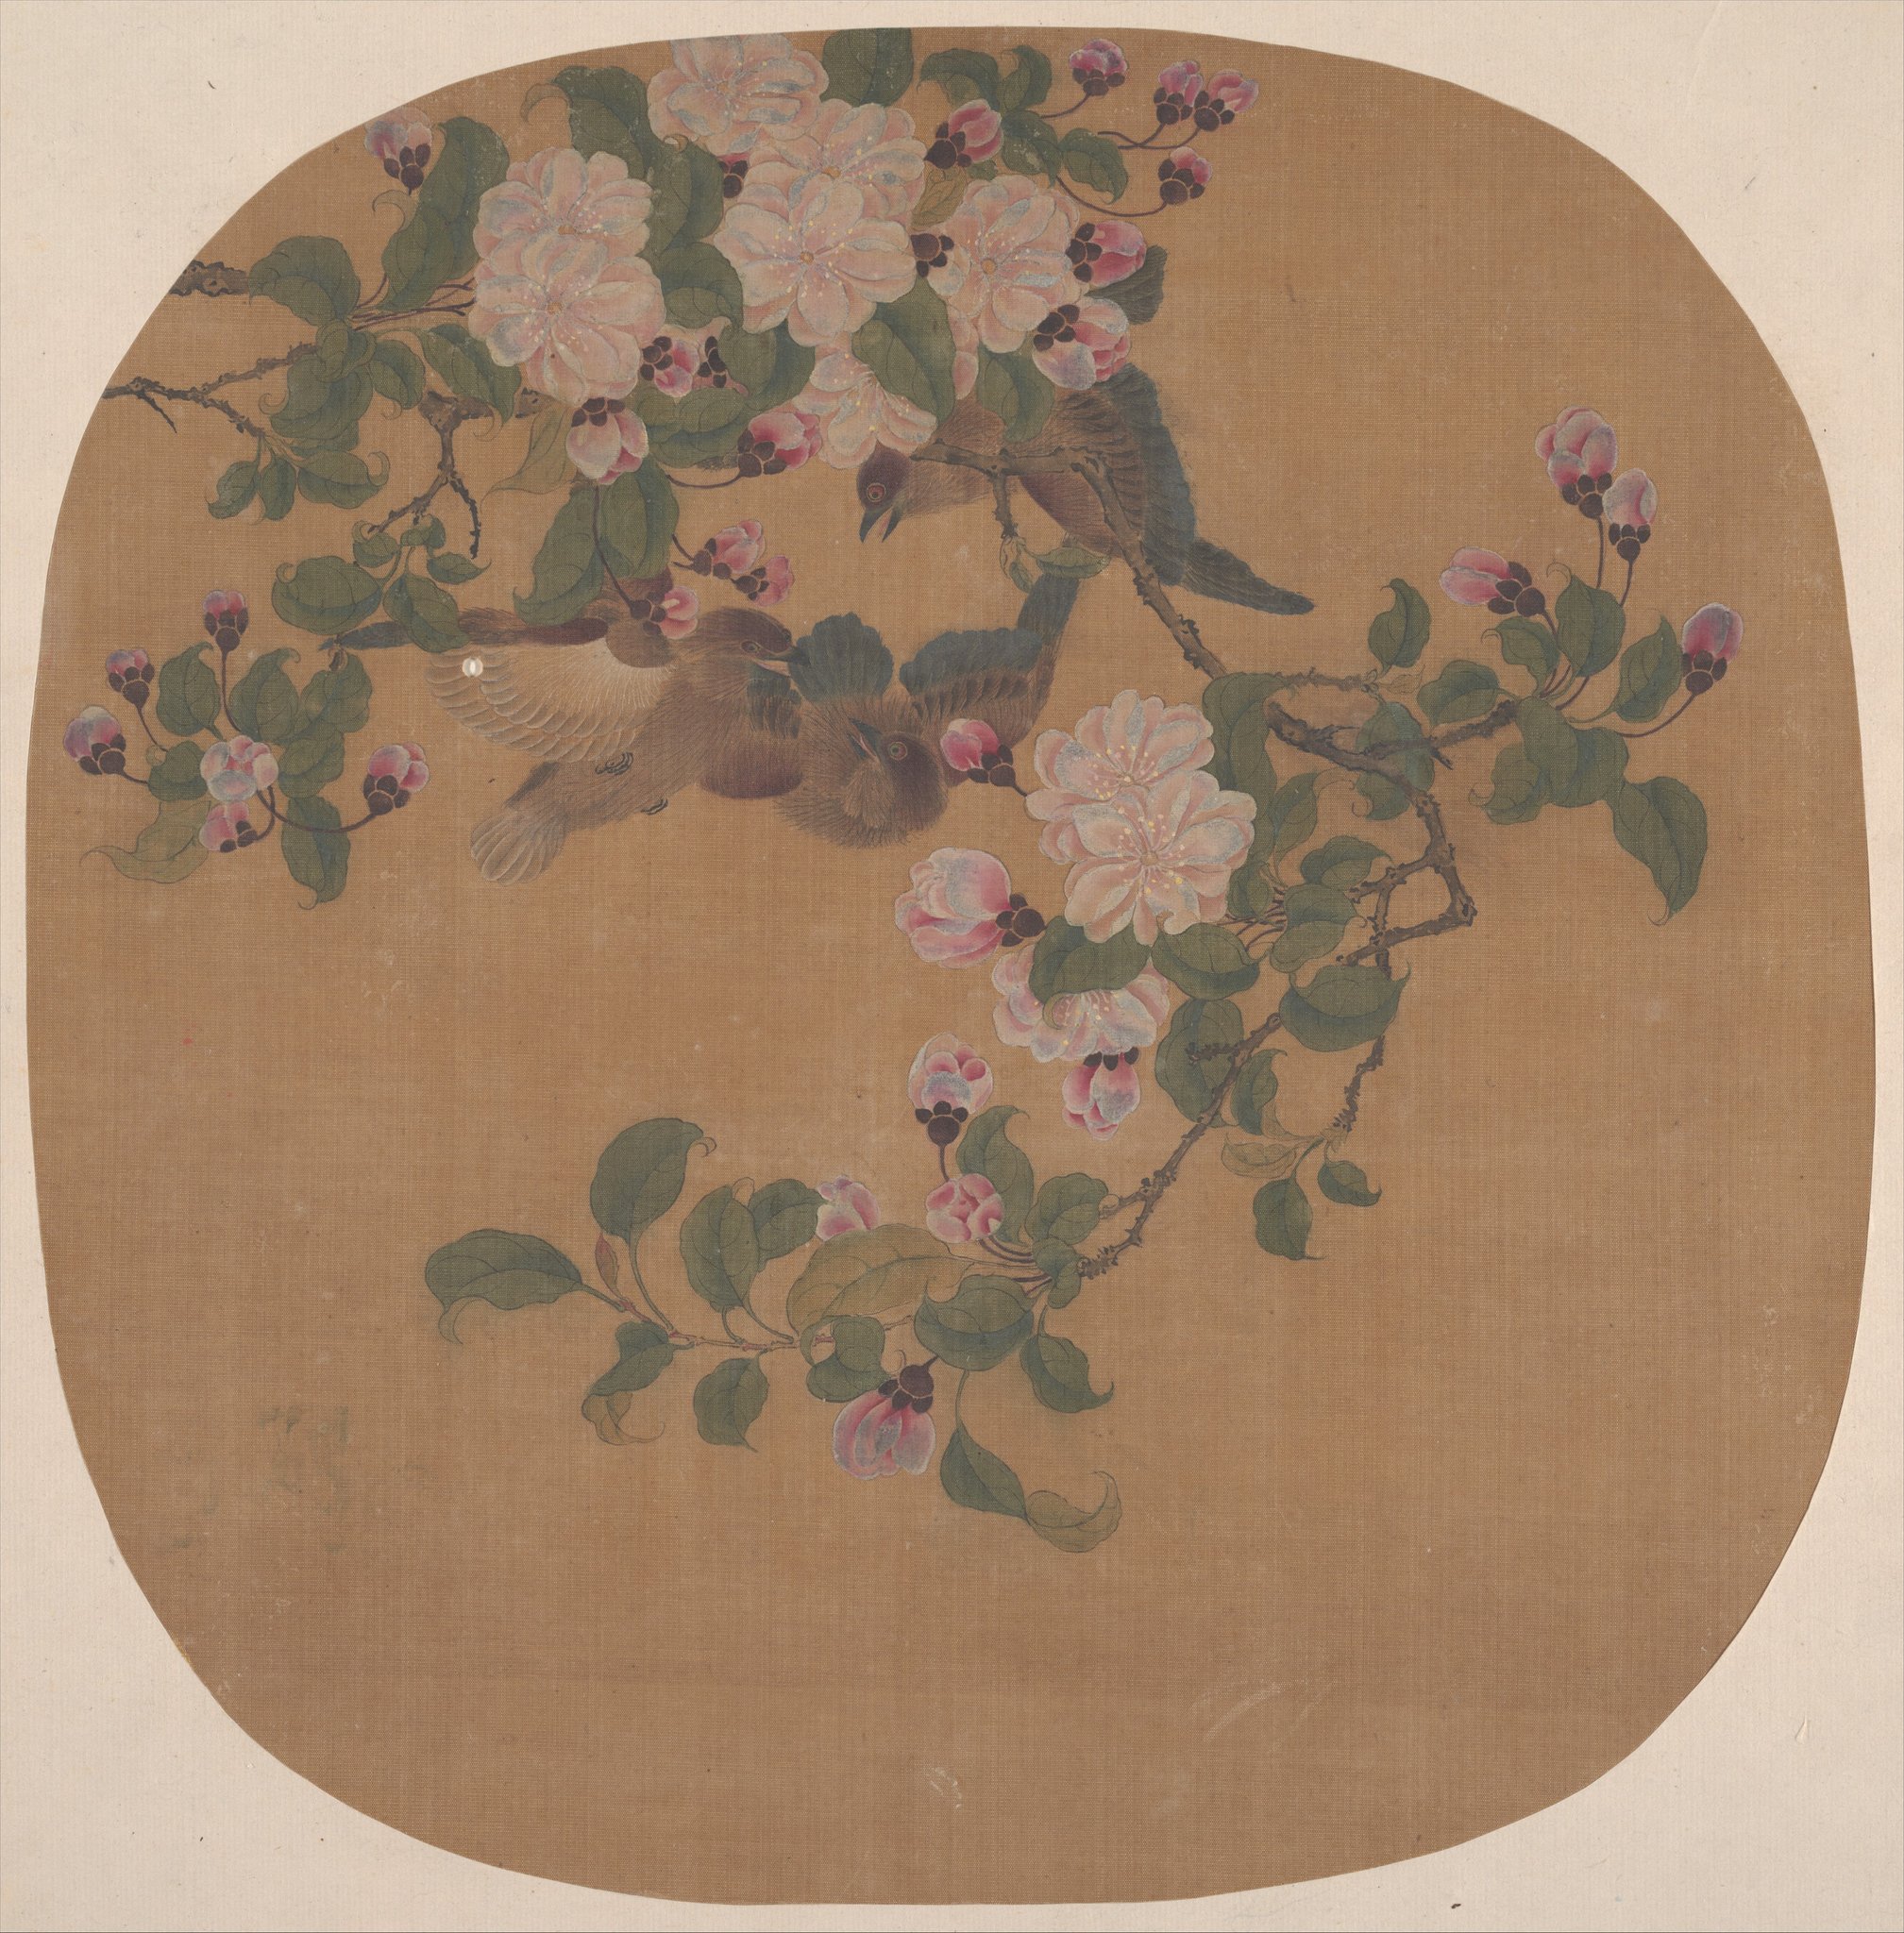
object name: fan mounted a an album leaf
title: Flowers with Birds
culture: chinese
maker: unidentified artist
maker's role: artist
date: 1368-1911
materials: ink, silk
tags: birds,flowers